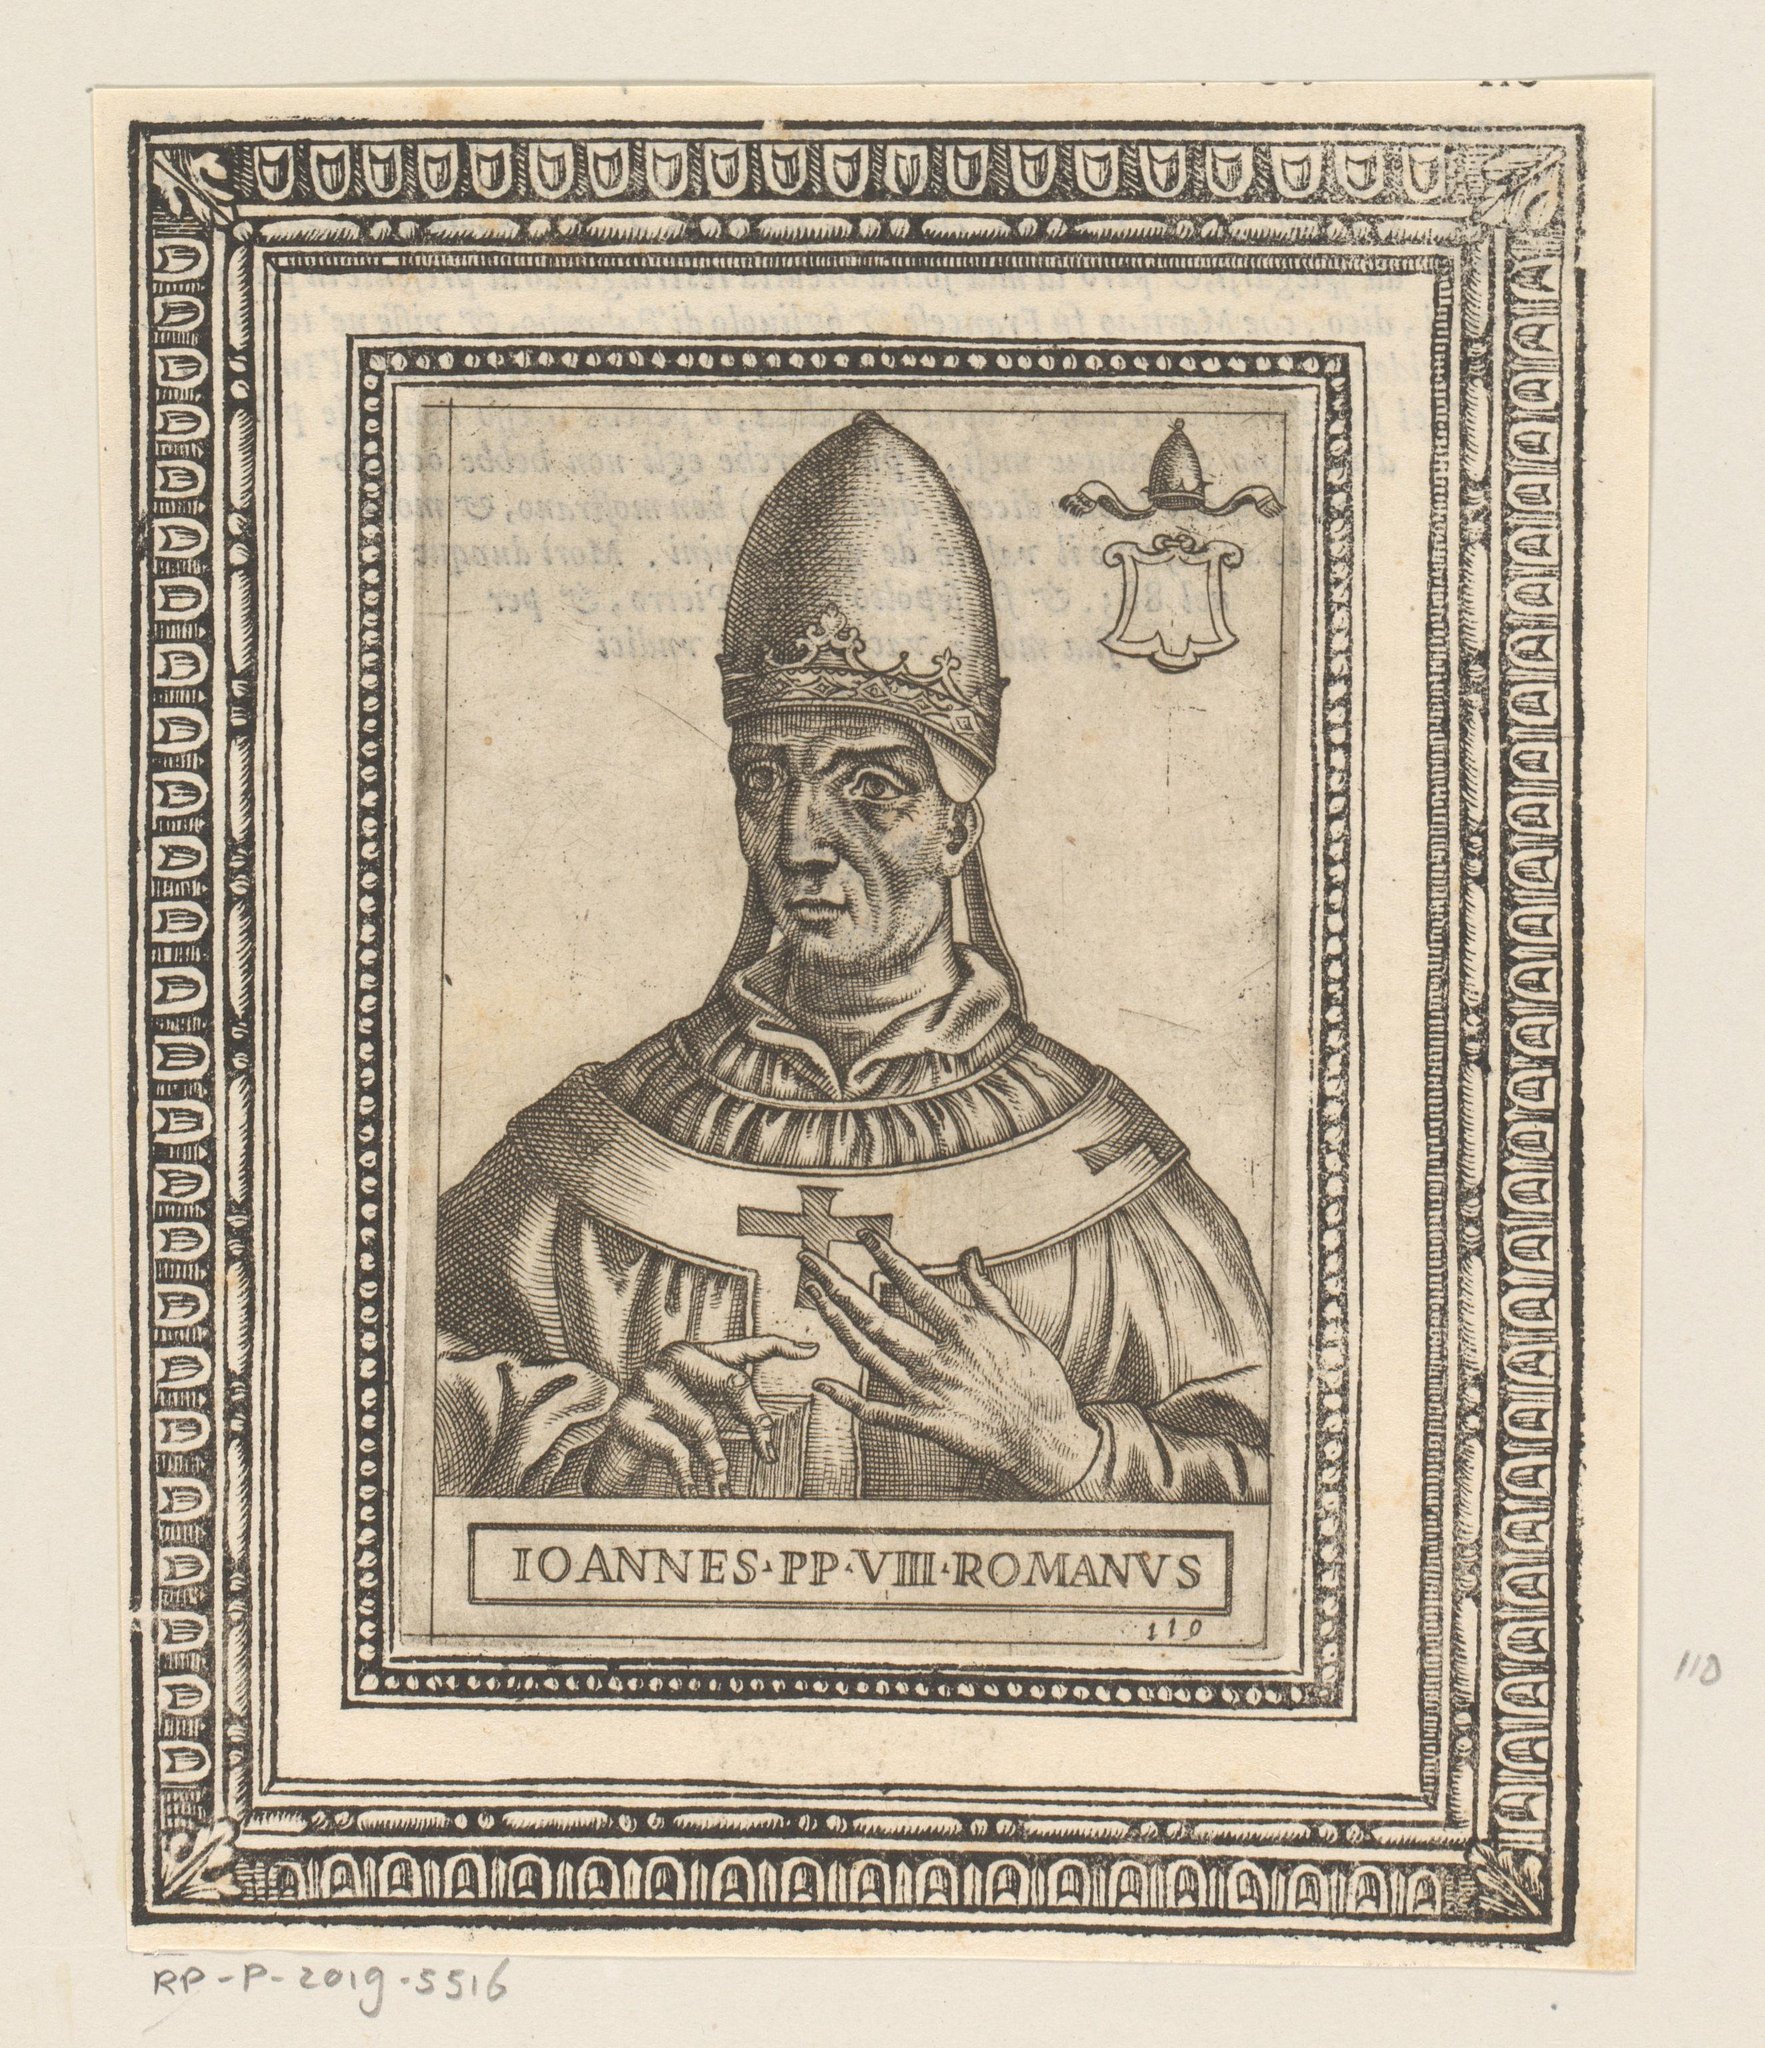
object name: print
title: Joannes PP VIII Romanus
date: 1587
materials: paper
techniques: engraving, letterpress printing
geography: rome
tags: historical persons, pope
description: Prent uit: Ciccarelli, Antonio. Le vite de Pontefici di Antonio Ciccarelli (...). Rome: Domenico Basa, 1587. Prent voor het eerst verschenen in: Cavalieri, Giovanni Battista de'. Pontificum romanorum effigies (...). Rome: Domenico Basa en Francesco Zanetti, 1580. Prent ook gebruikt in latere publicaties.